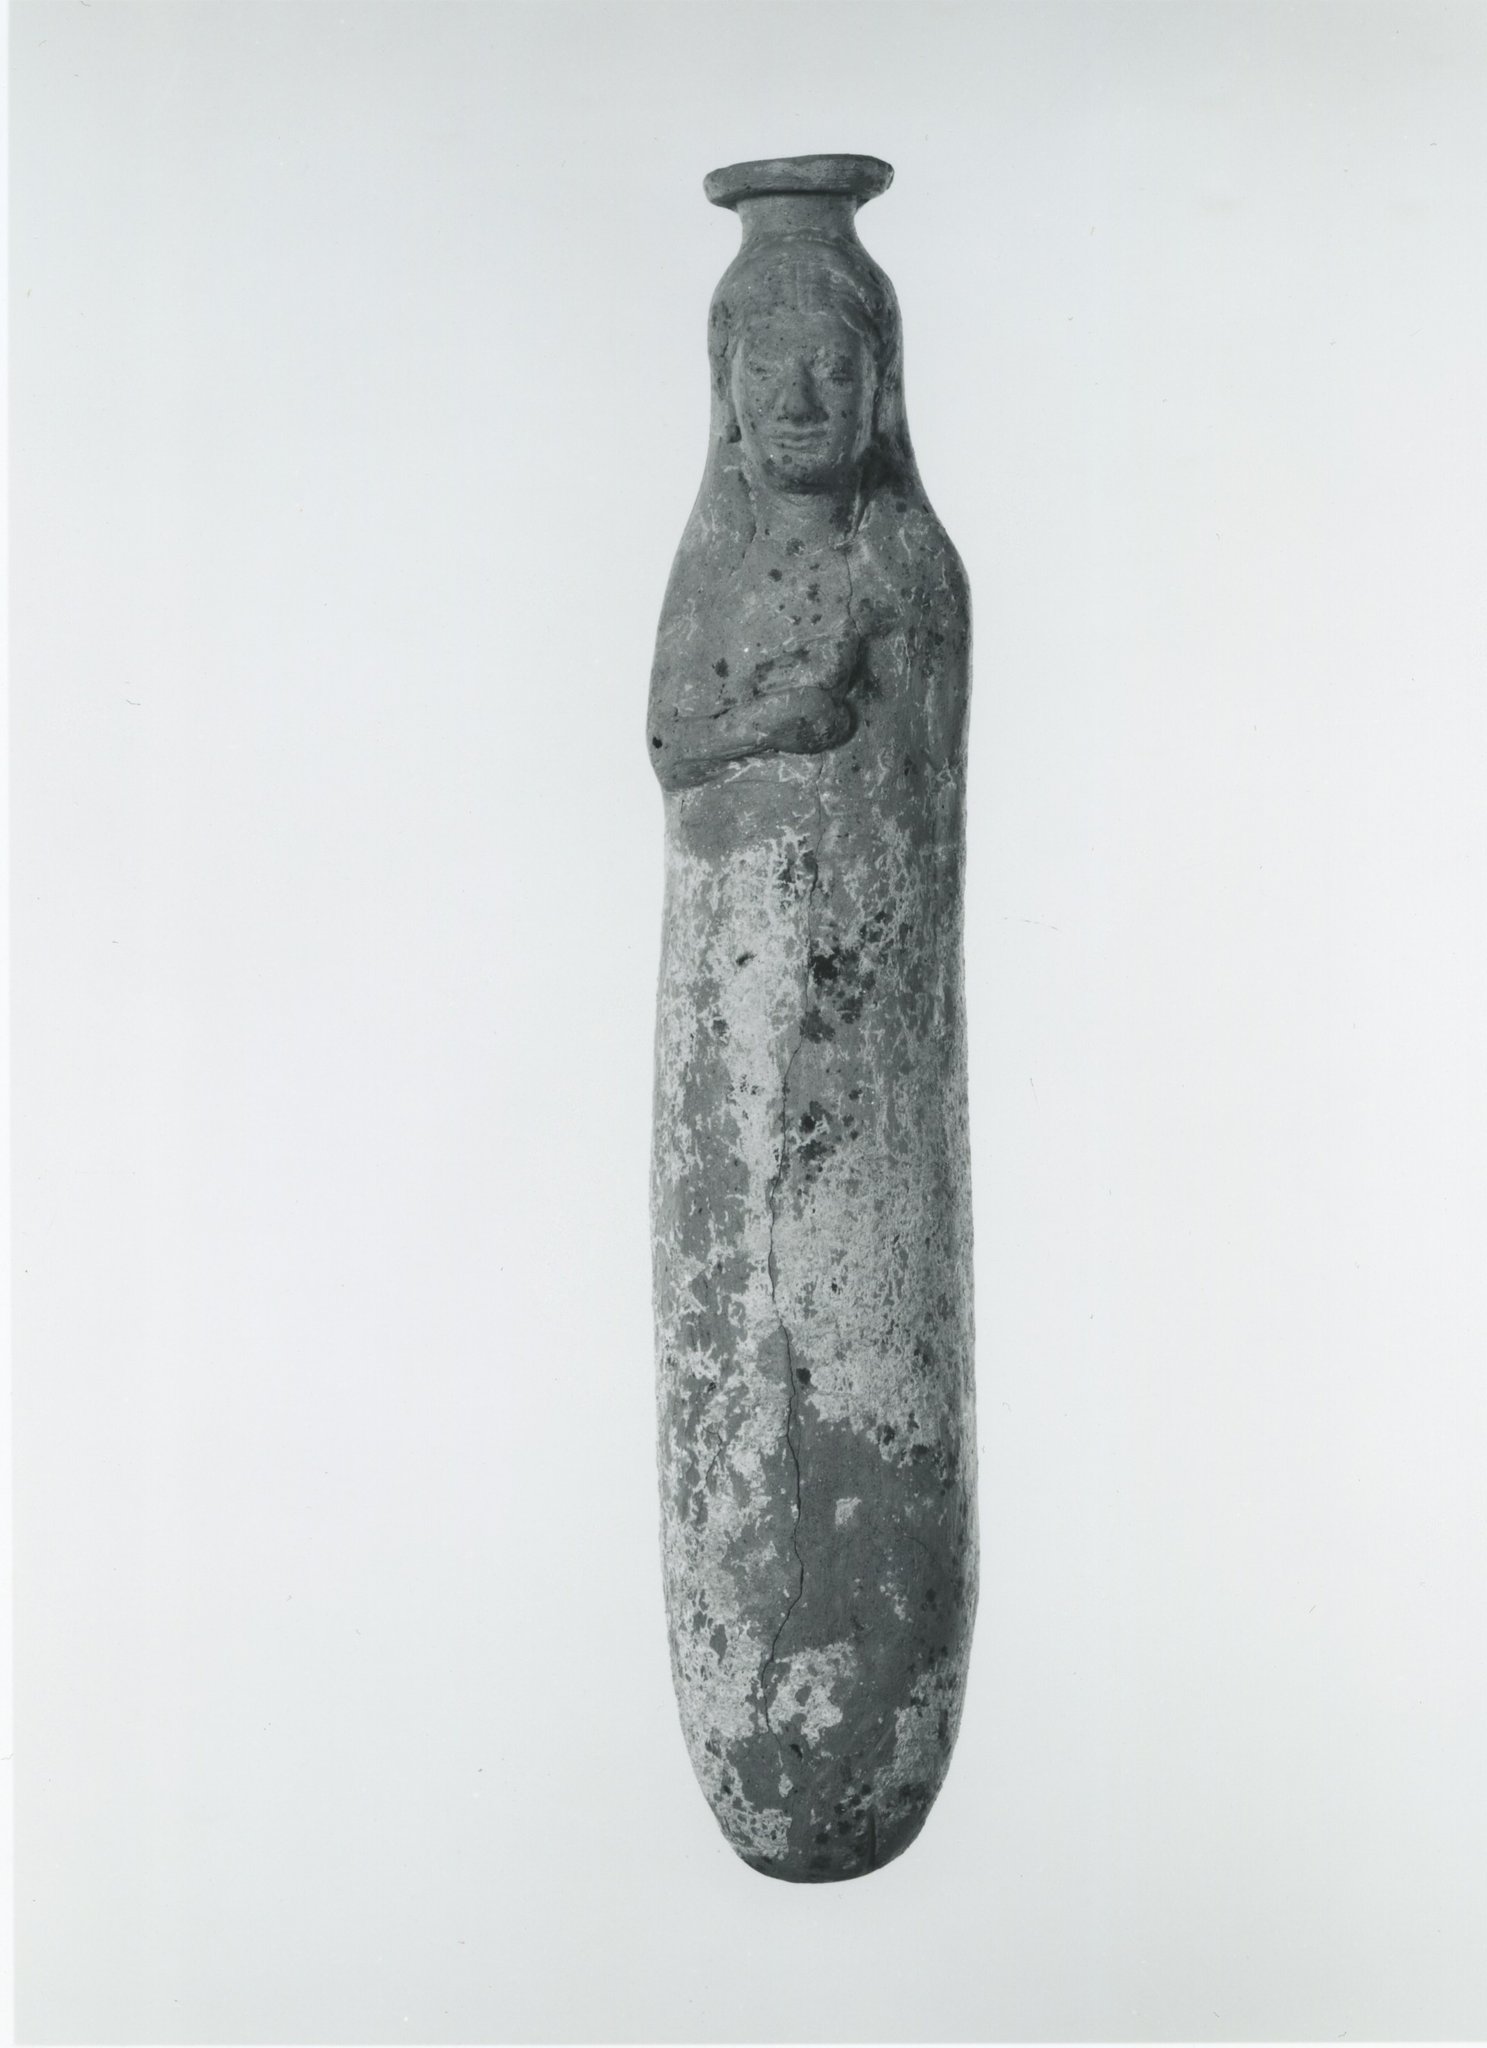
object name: alabastron in the form of a woman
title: Terracotta alabastron in the form of a woman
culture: east greek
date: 600-501 BCE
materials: terracotta